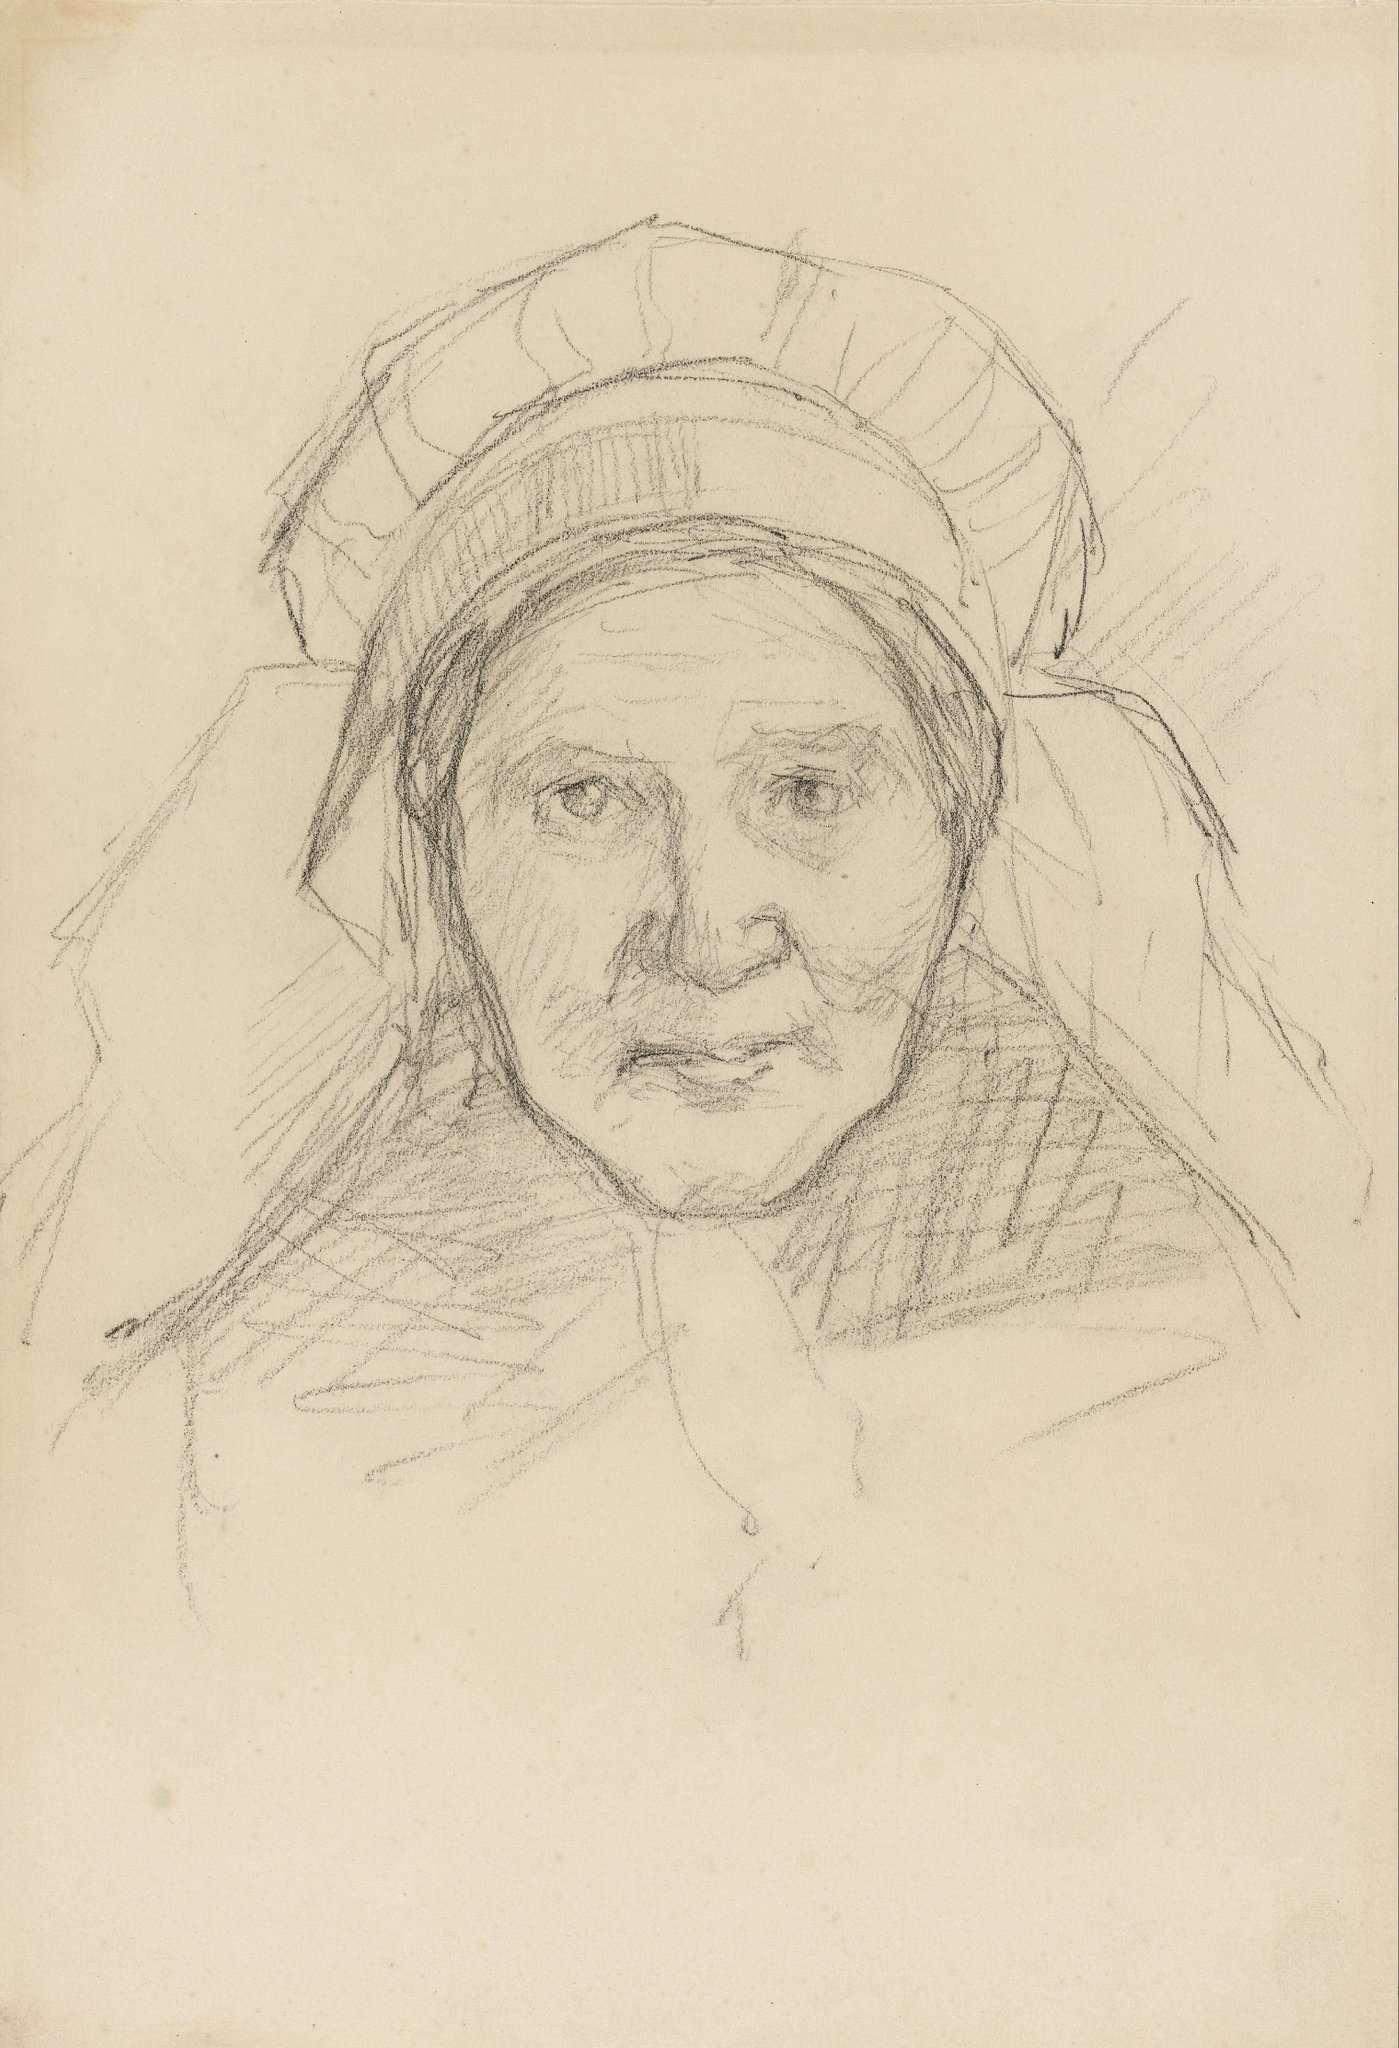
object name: drawing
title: Hoofd van een boerin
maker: jozef israëls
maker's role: draughtsman, painter, print maker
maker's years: 1824-1911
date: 1834-1911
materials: chalk, paper